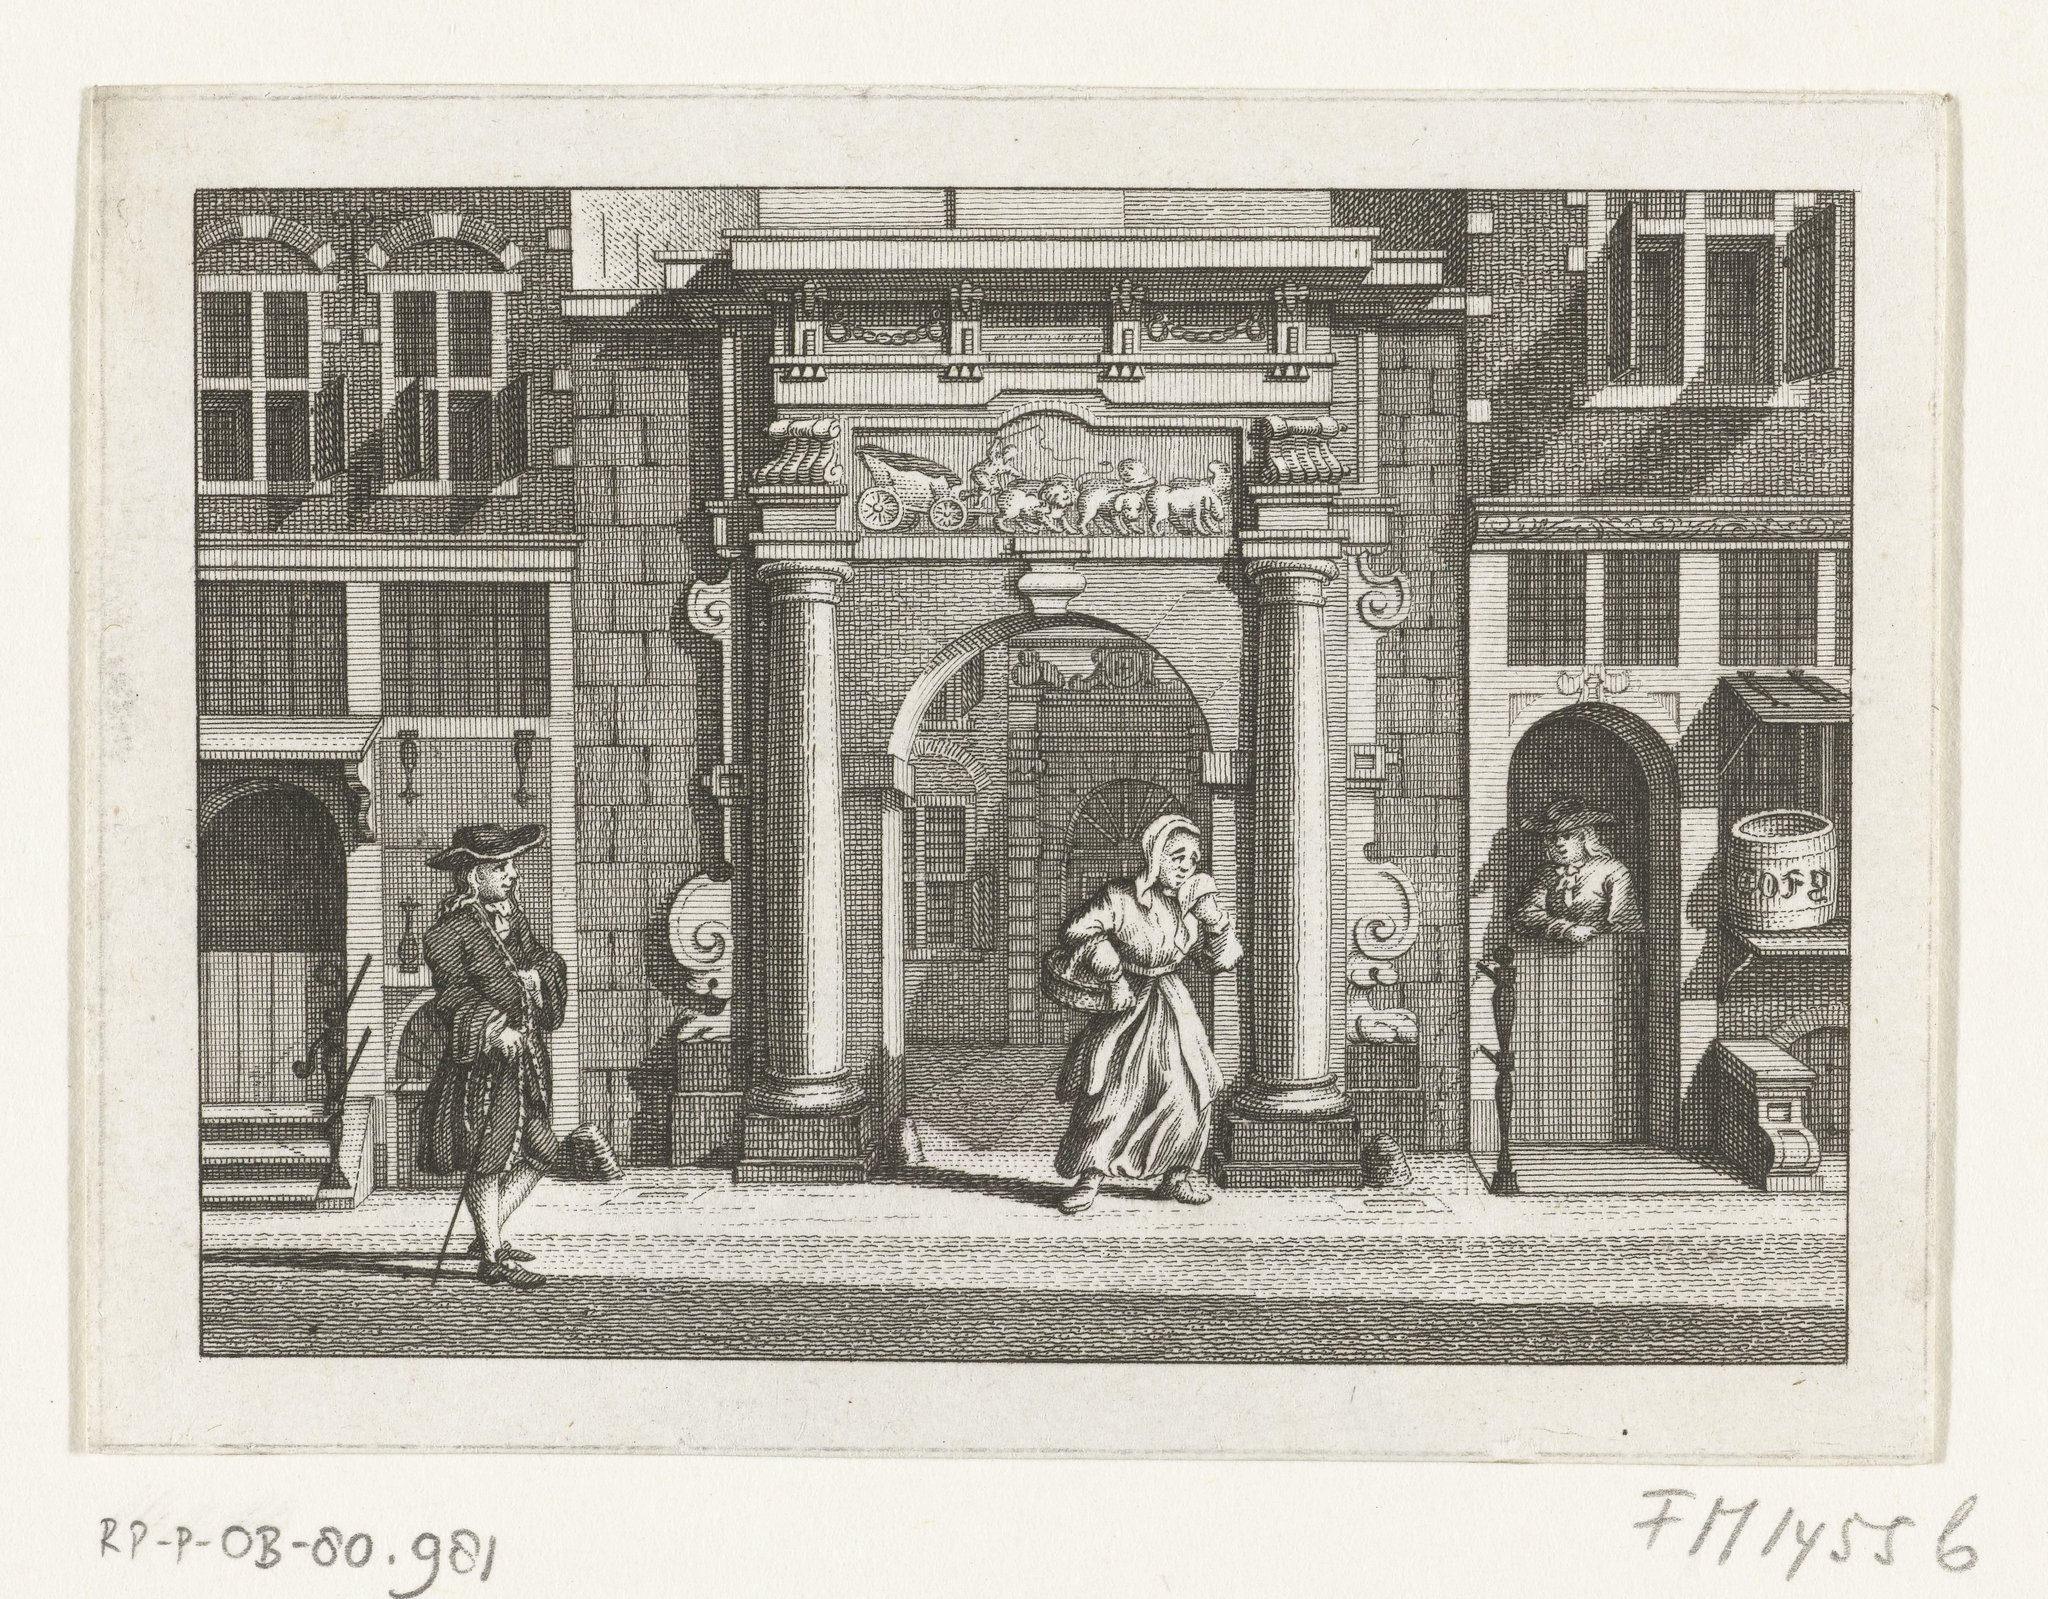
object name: print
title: Dominicus Sapma ontsnapt in de kleding van zijn vrouw uit het Rasphuis te Amsterdam, 1621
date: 1780-1782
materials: paper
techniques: etching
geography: netherlands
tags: law and jurisprudence (+ escape from prison)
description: Gebruikt als illustratie in: L. van Ollefen, Verkorte beschryving van Amsteldam, geschikt voor de opvoeding der jeugd, J.B. Elwe, Amsterdam 1782.